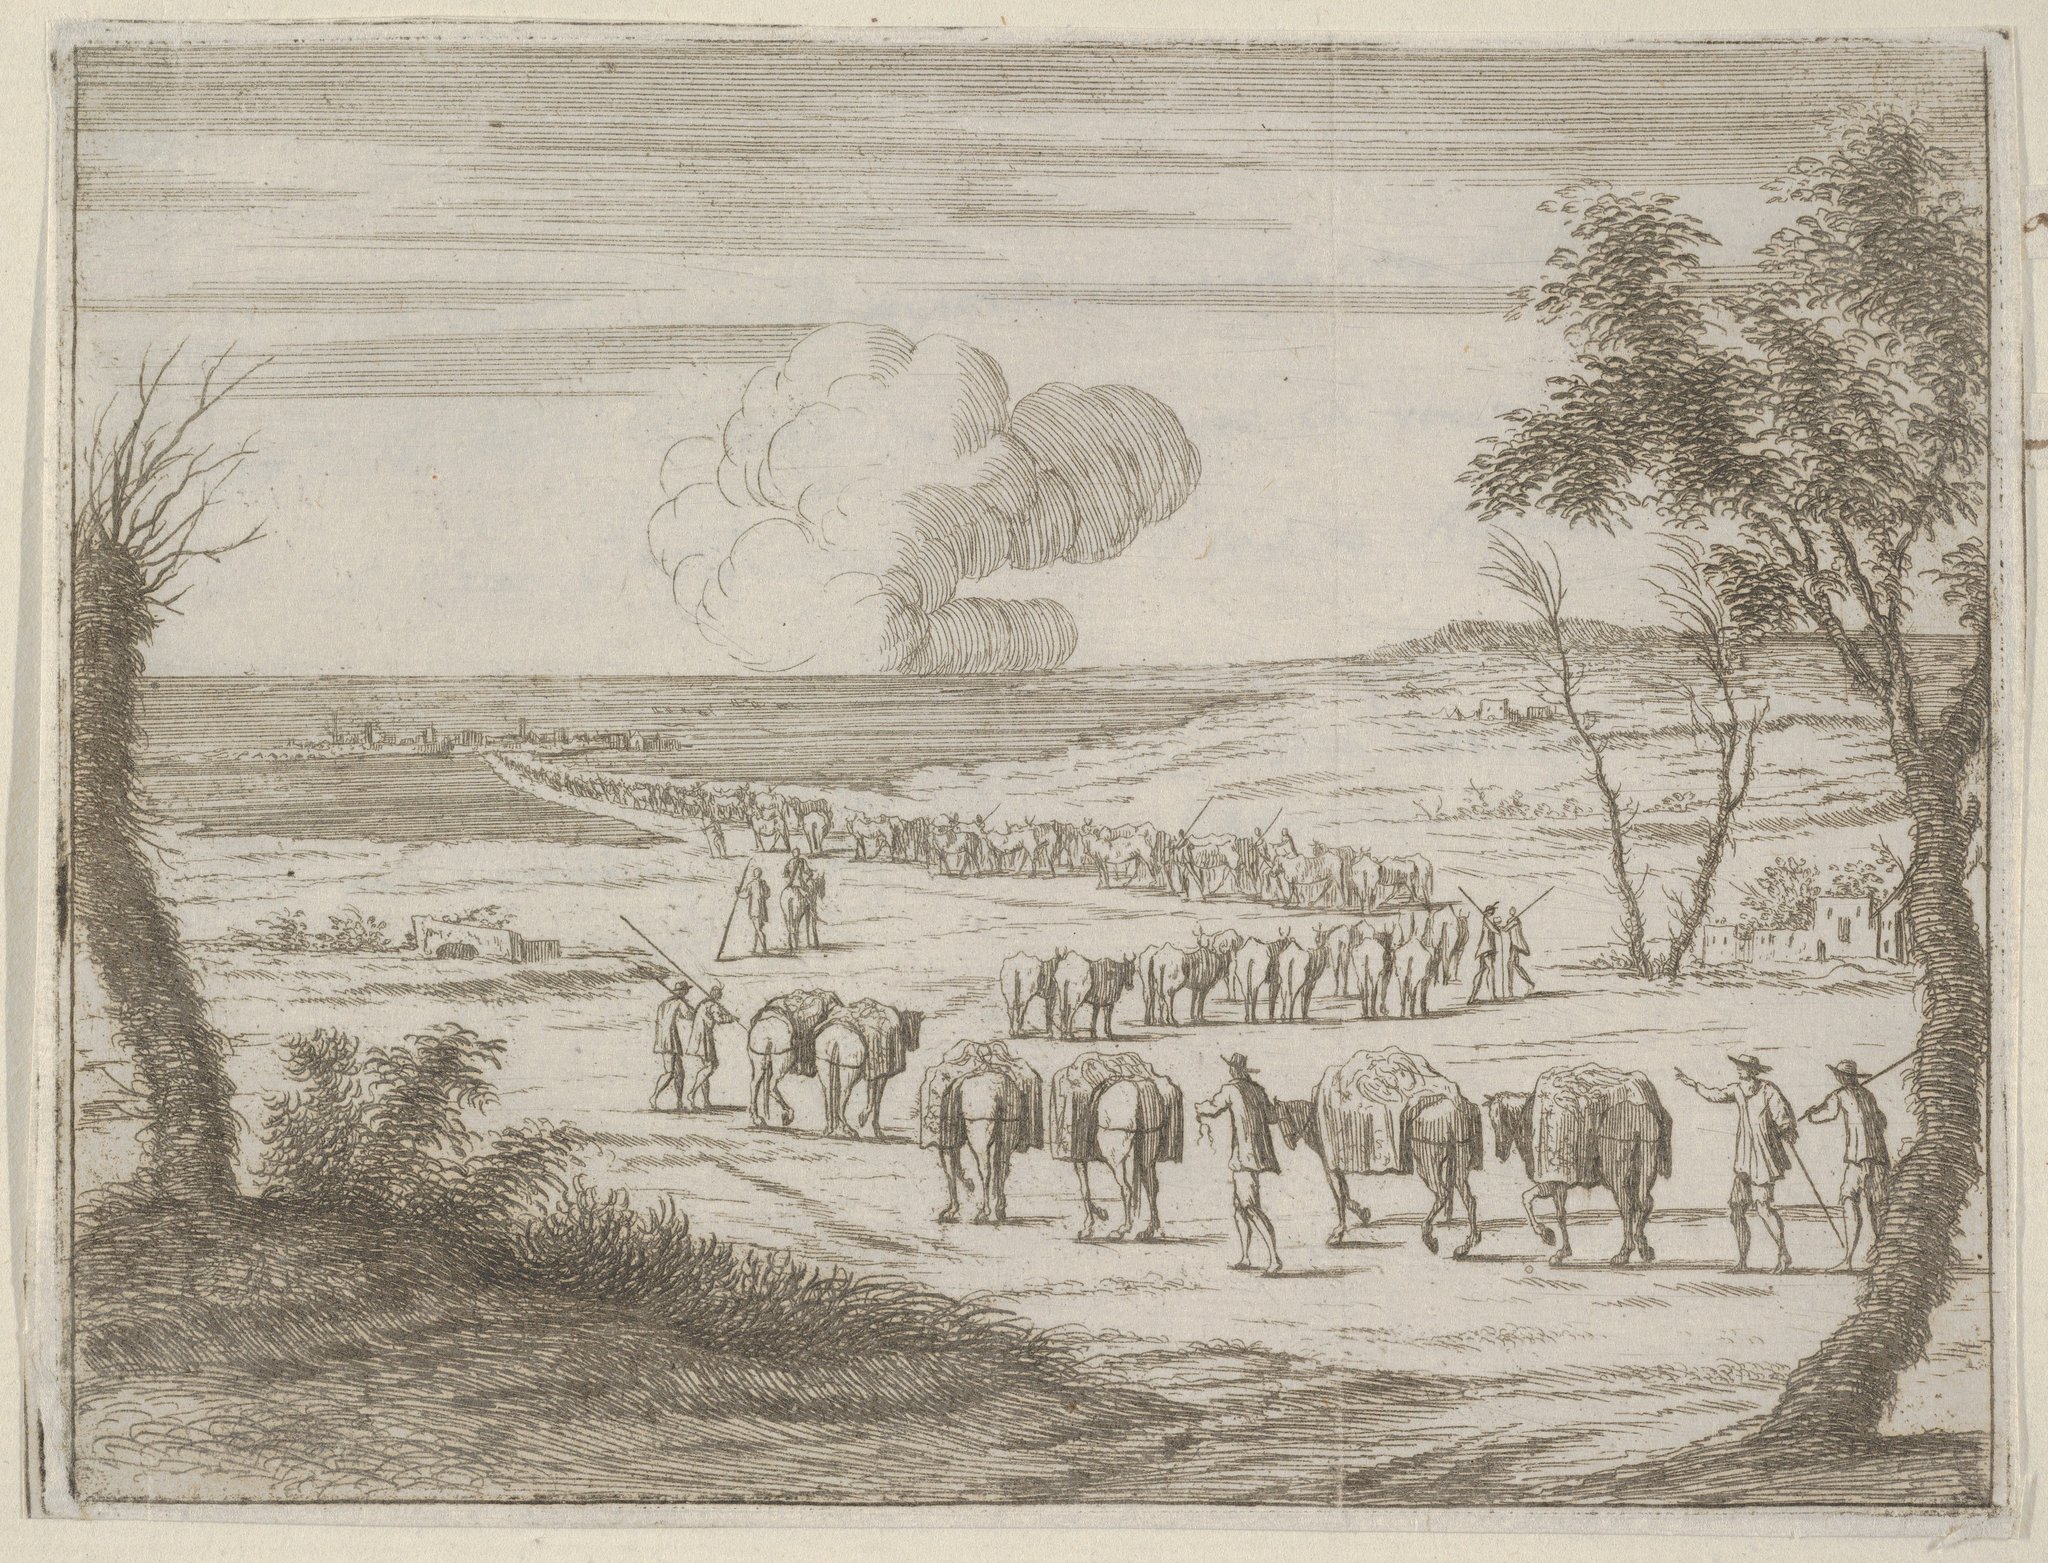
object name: print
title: Francesco I d'Este Aids the Duke of Mantua After his Territories were Devastated by the German Armies, from "L'Idea di un Principe ed Eroe Cristiano in Francesco I d'Este, di Modena e Reggio Duca VIII [...]"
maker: bartolomeo fenice (fénis)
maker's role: artist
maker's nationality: italian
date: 1659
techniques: etching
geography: italy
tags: animals,men,trees